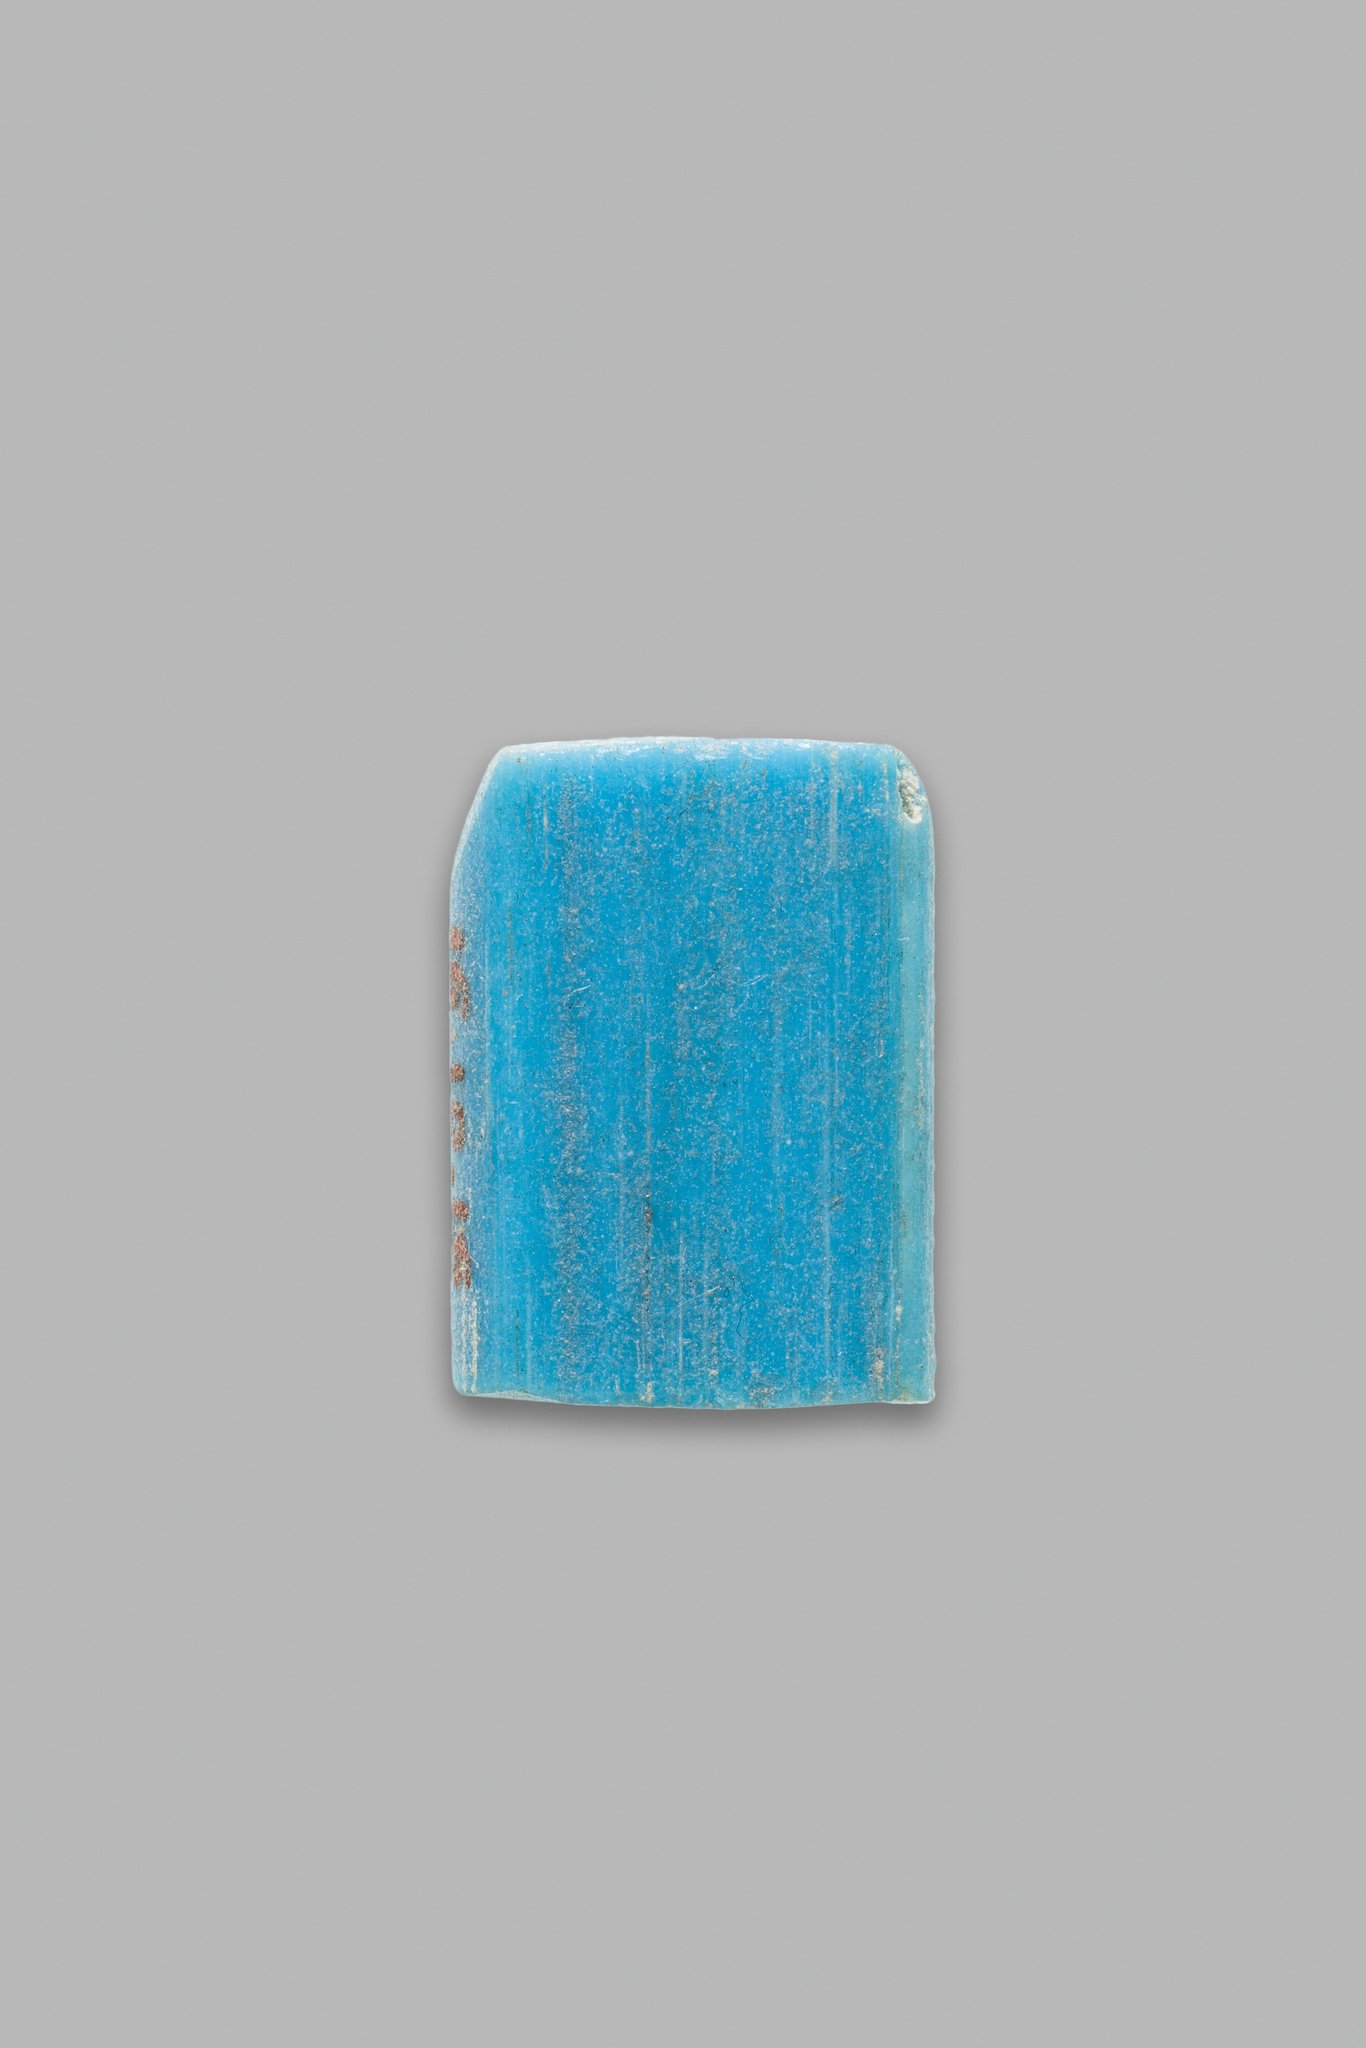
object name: foundation deposit, plaque, rectangular, ramesses iv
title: Rectangular Plaque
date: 1153-1147 BCE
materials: glass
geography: egypt